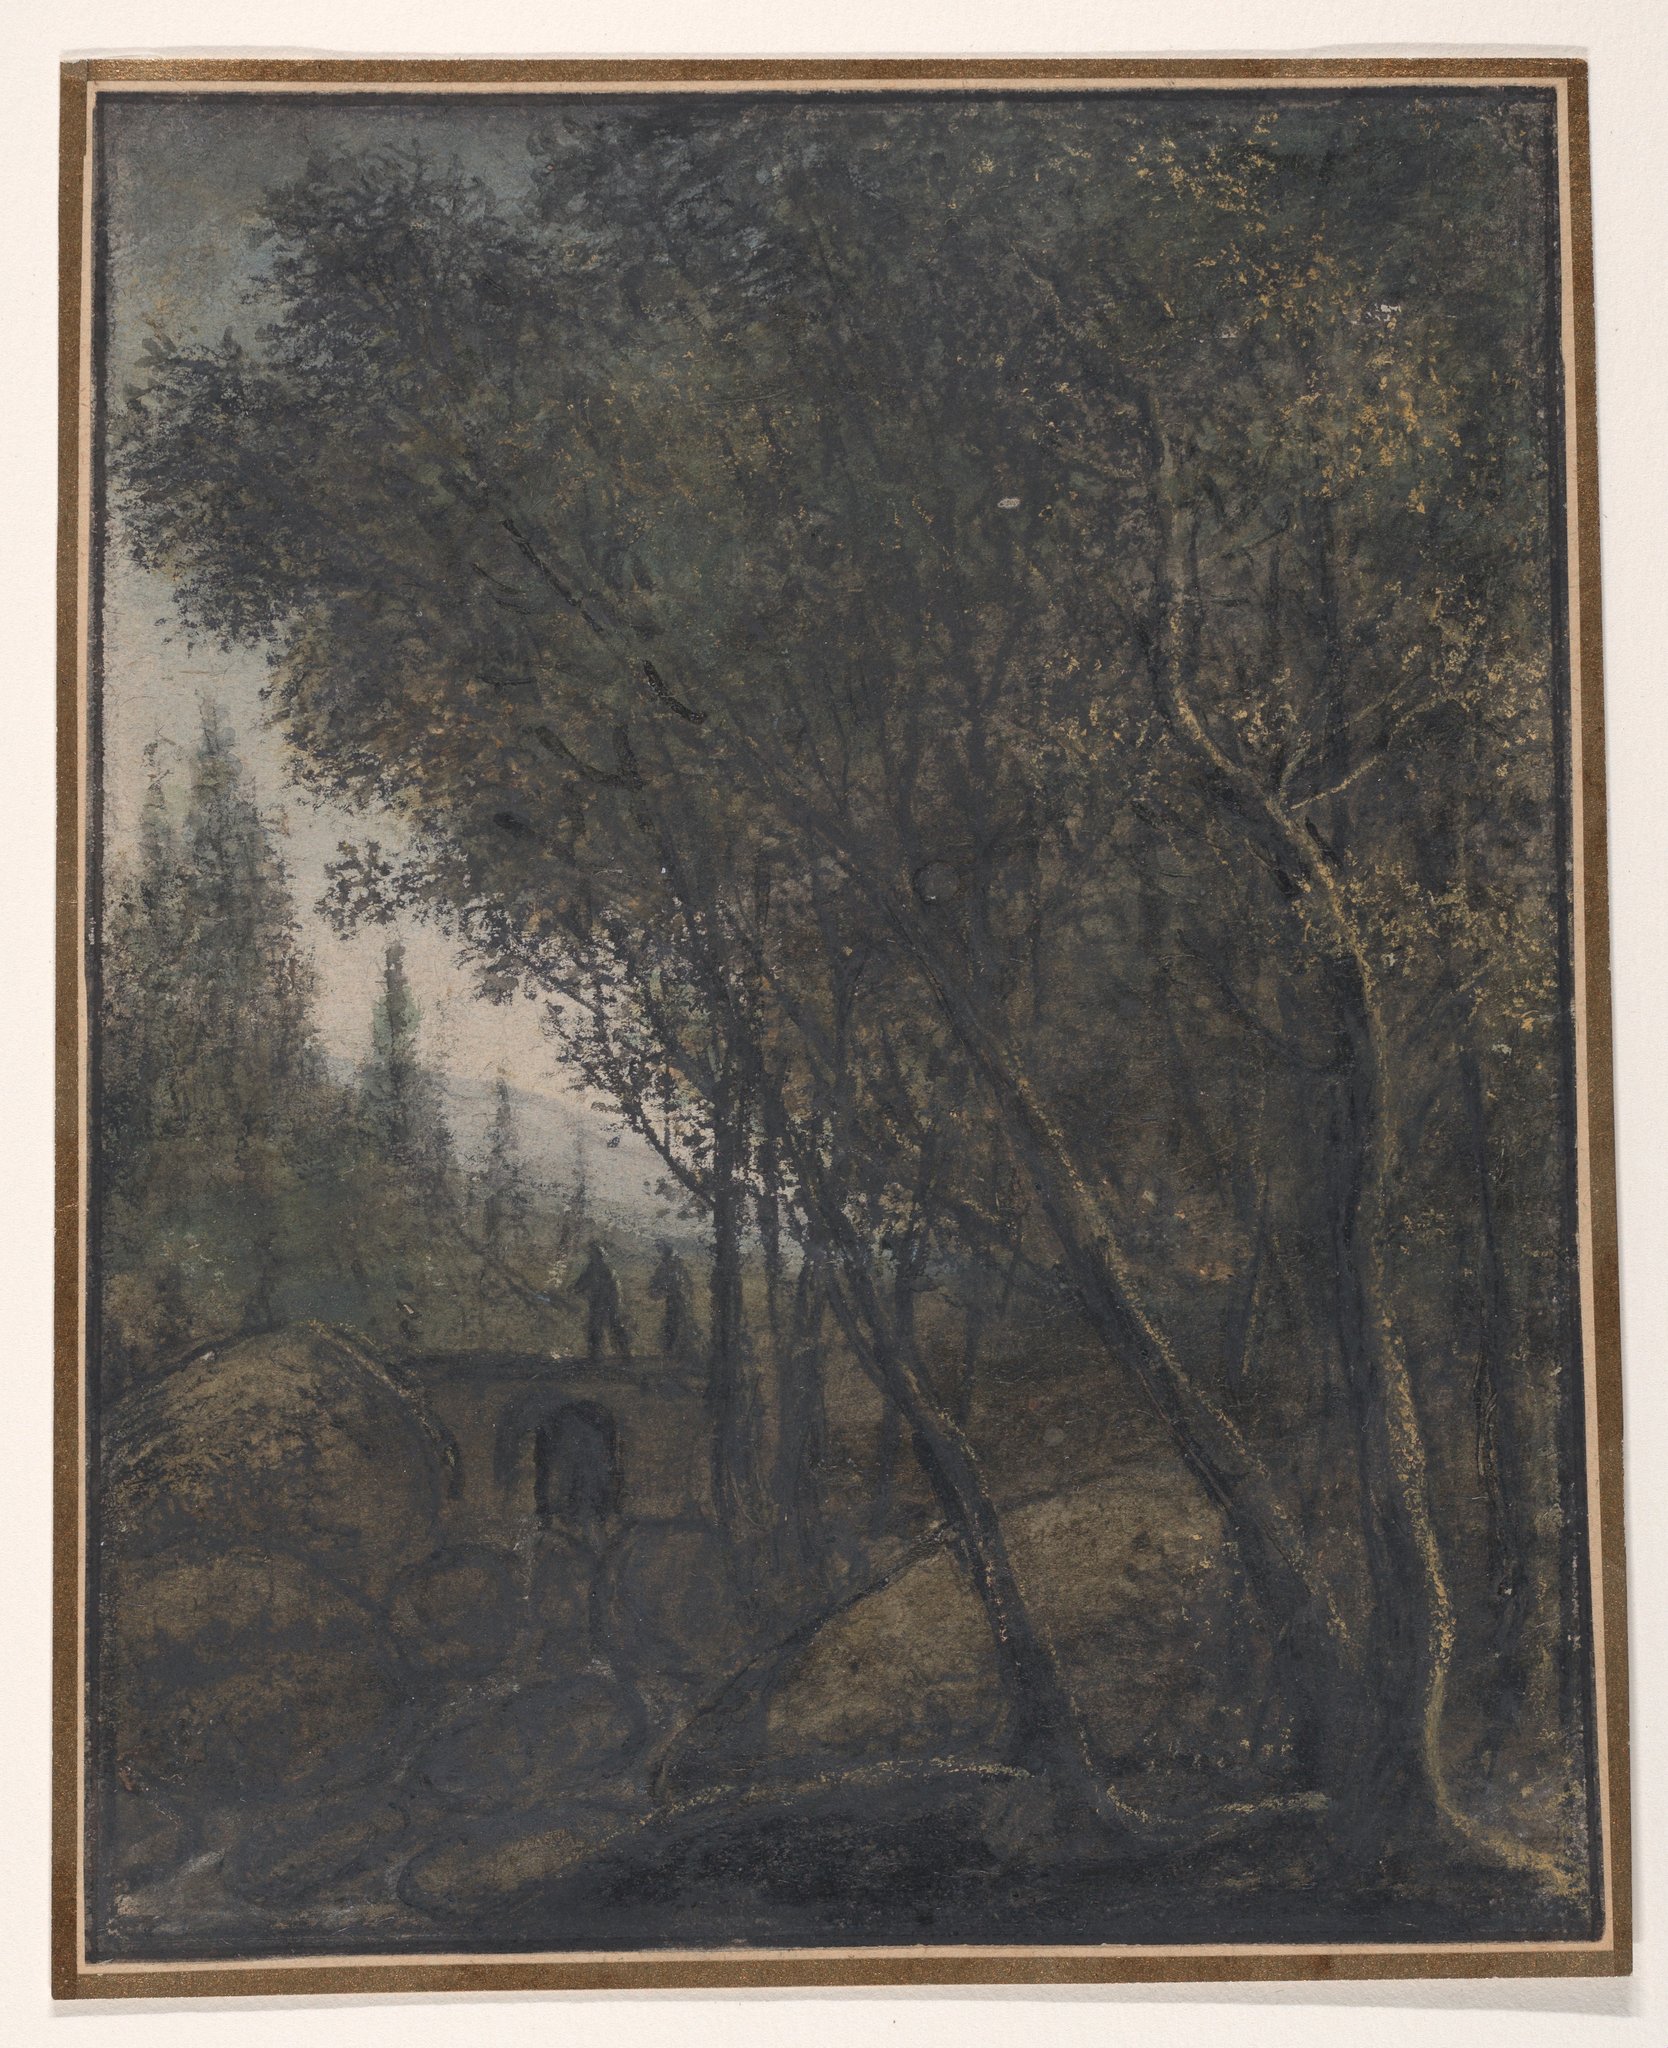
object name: drawing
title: A Wooded Landscape with Travelers Crossing a Small Bridge over a River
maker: anthonie waterloo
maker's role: artist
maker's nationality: dutch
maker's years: 1609-1690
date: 1629-1690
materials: chalk, gouache, ink, paper, watercolor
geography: netherlands